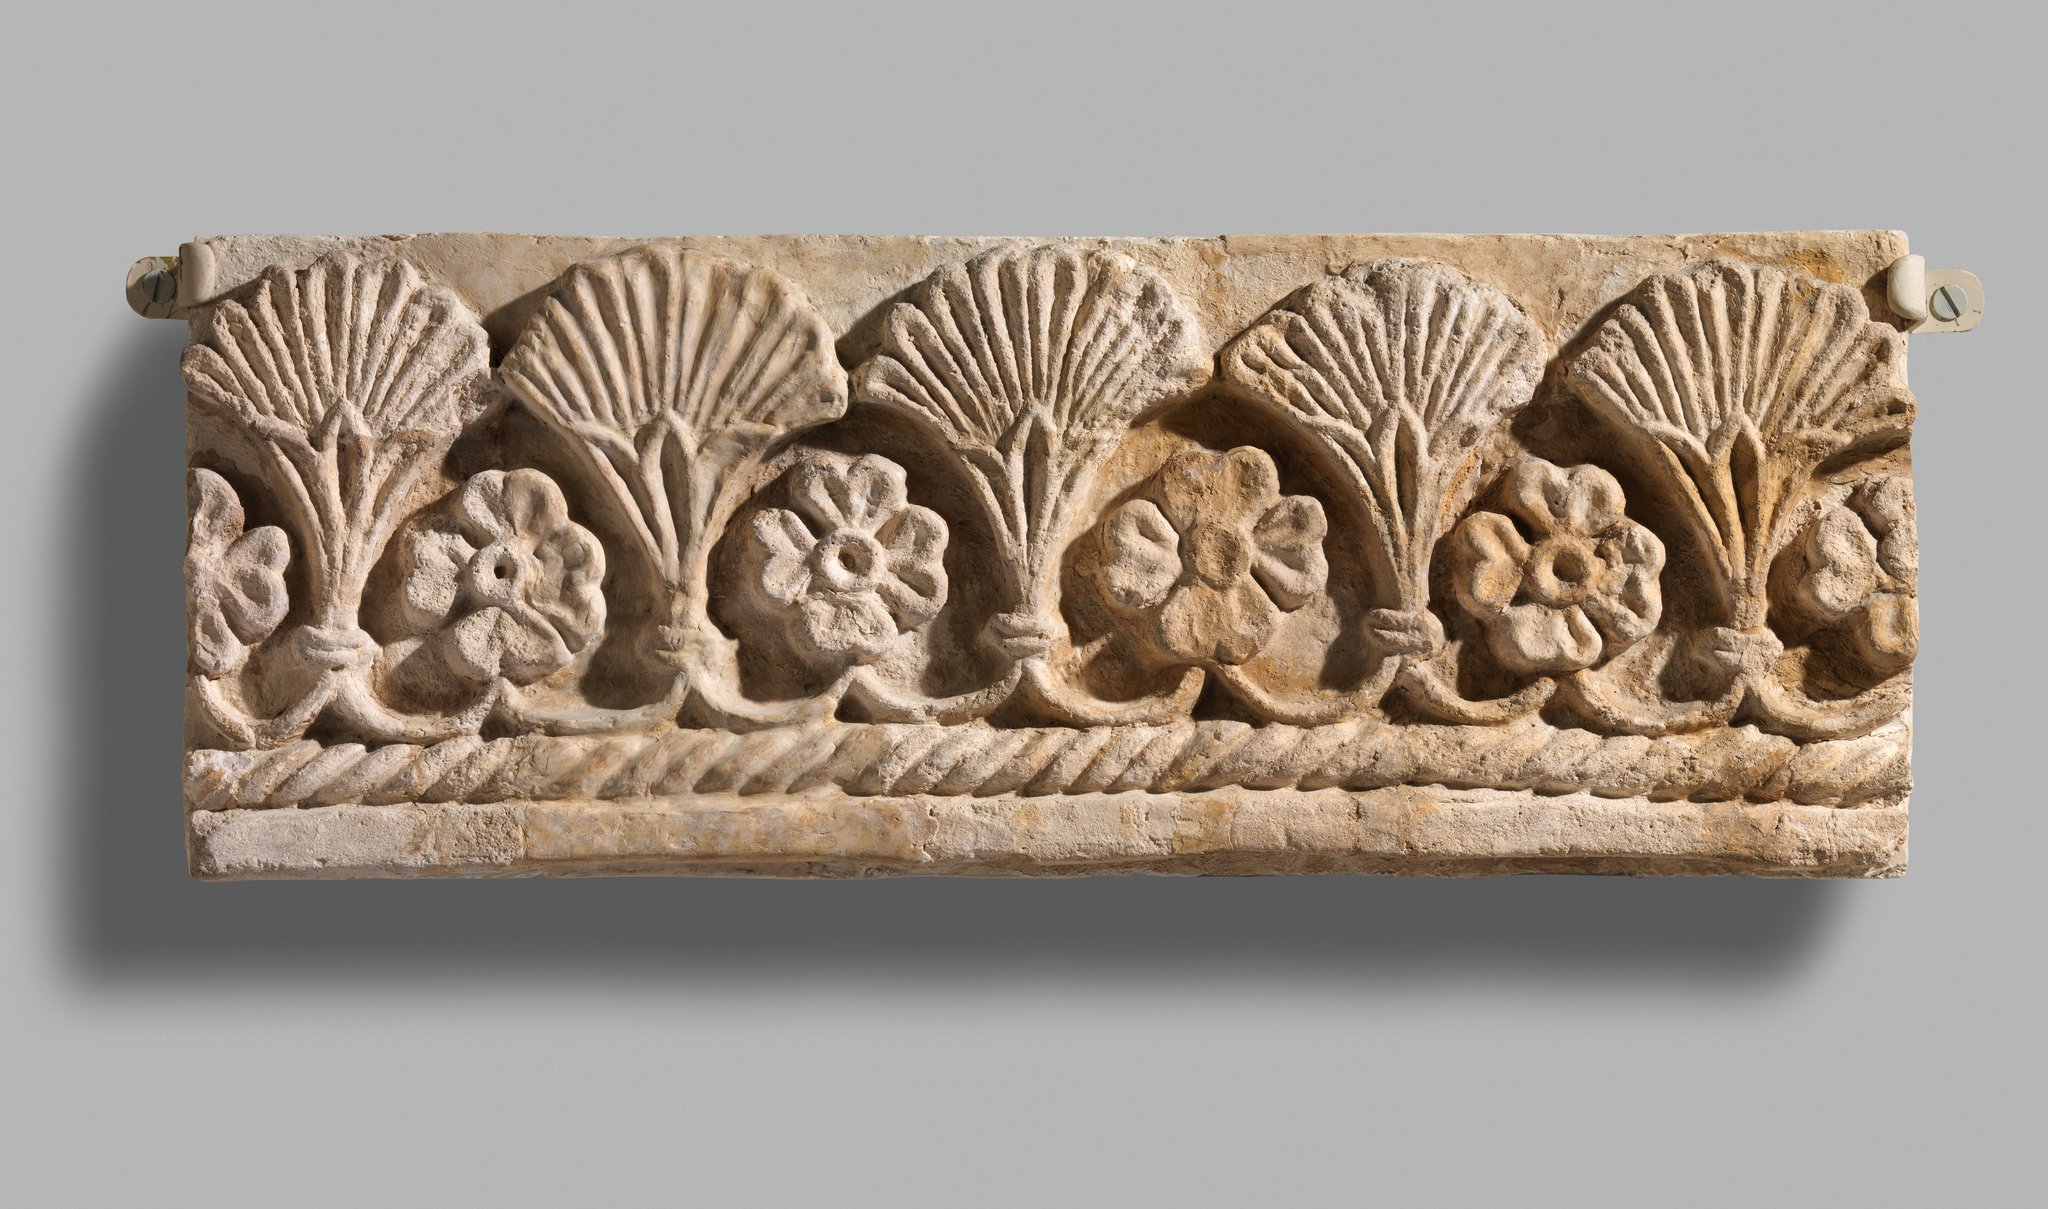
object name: relief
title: Wall decoration with vegetal design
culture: sasanian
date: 501-600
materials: plaster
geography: mesopotamia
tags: flowers